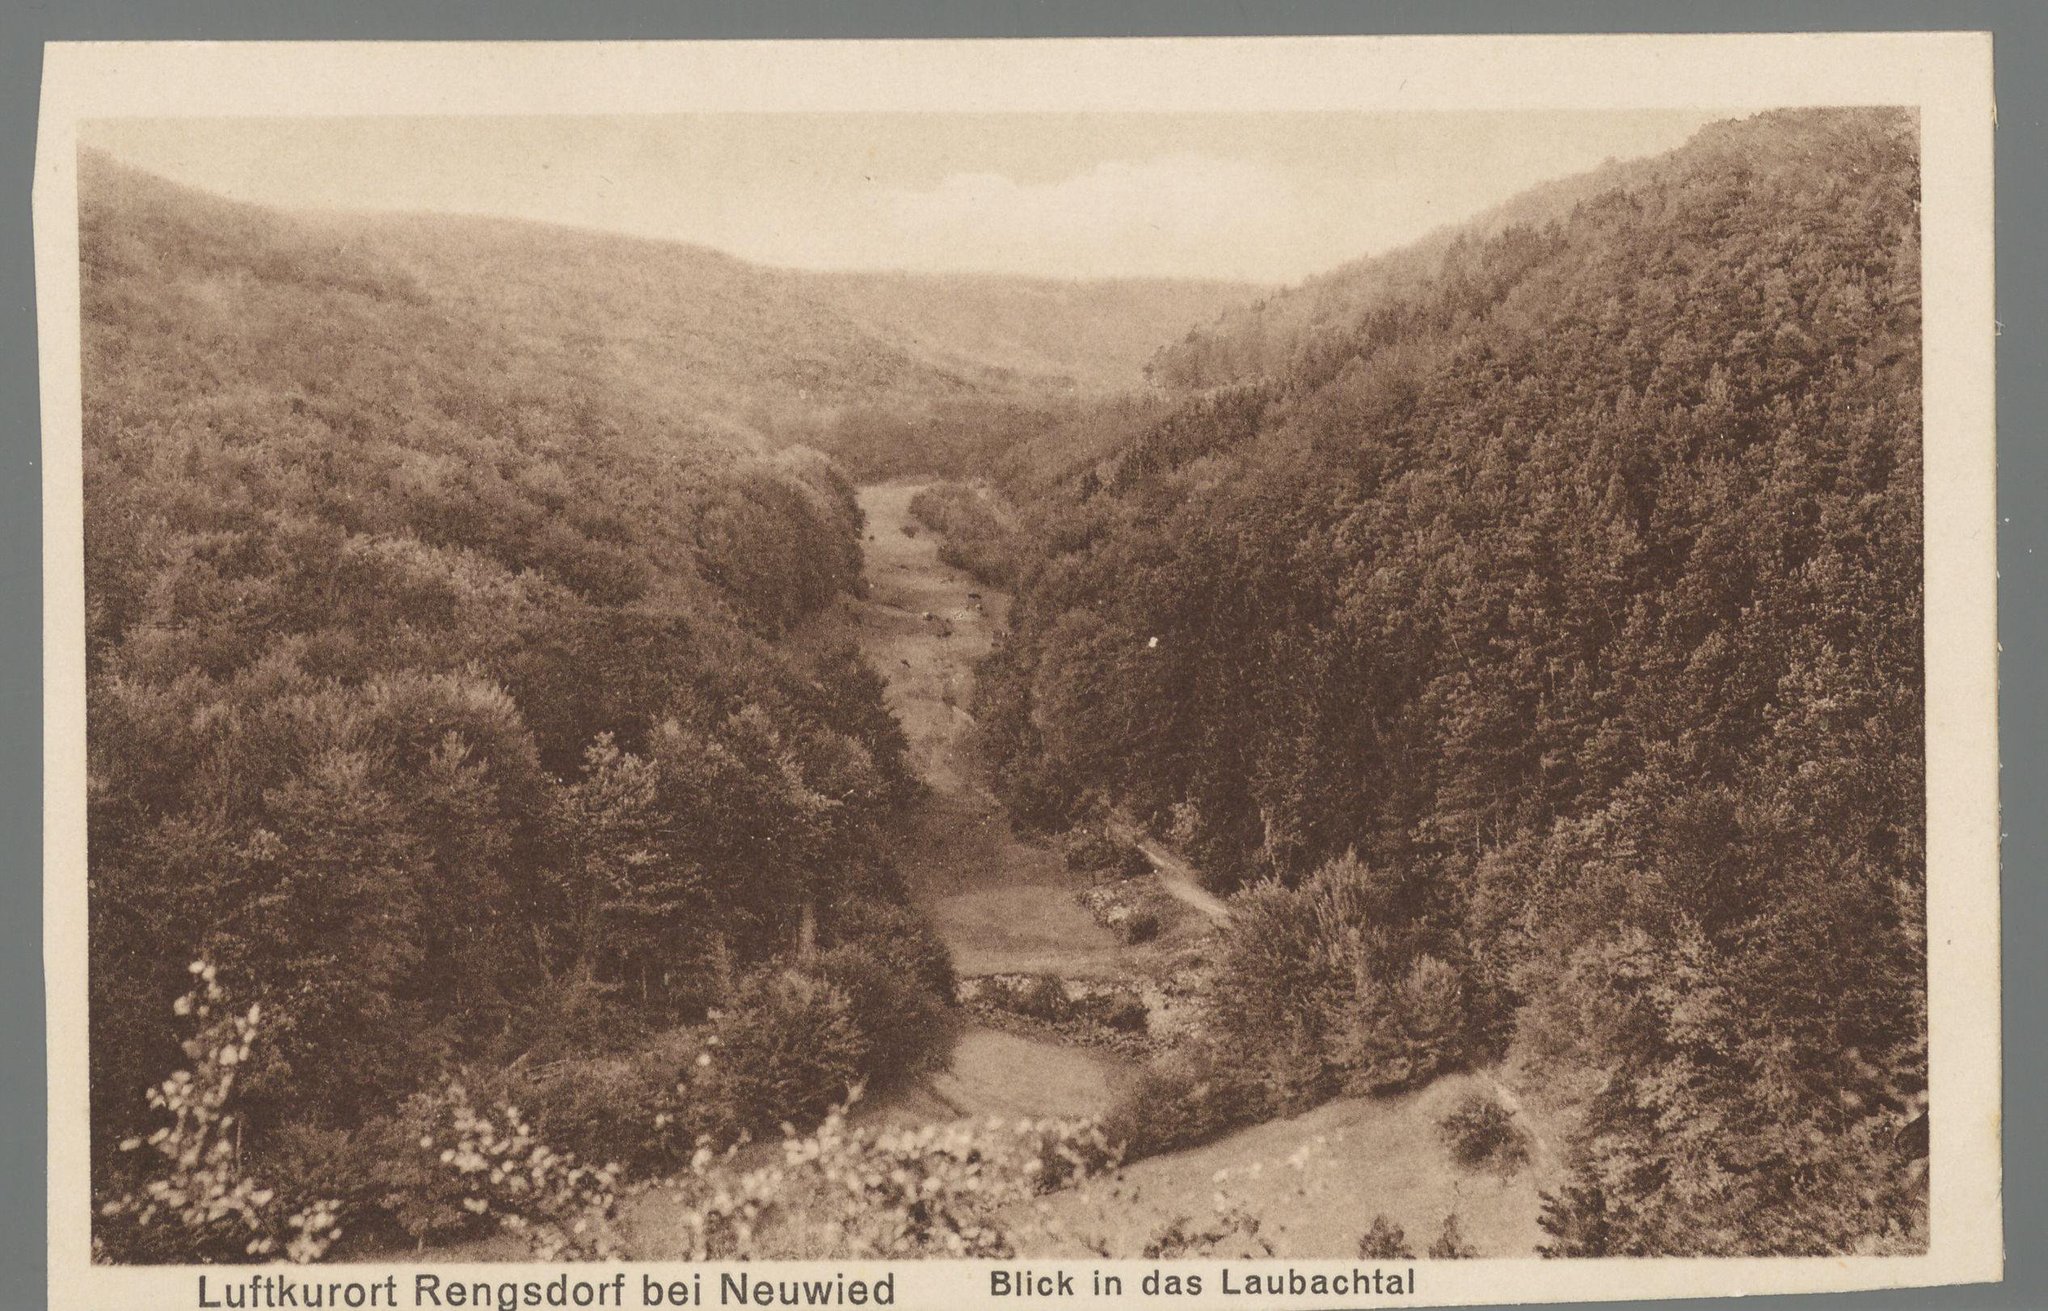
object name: ansichtkaart, prentbriefkaart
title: Luftkurort Rengsdorf bei Neuwied. Blick in das Laubachtal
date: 1905-1930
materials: cardboard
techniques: photograph, writing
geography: rengsdorf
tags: dale, valley, watering-place, spa